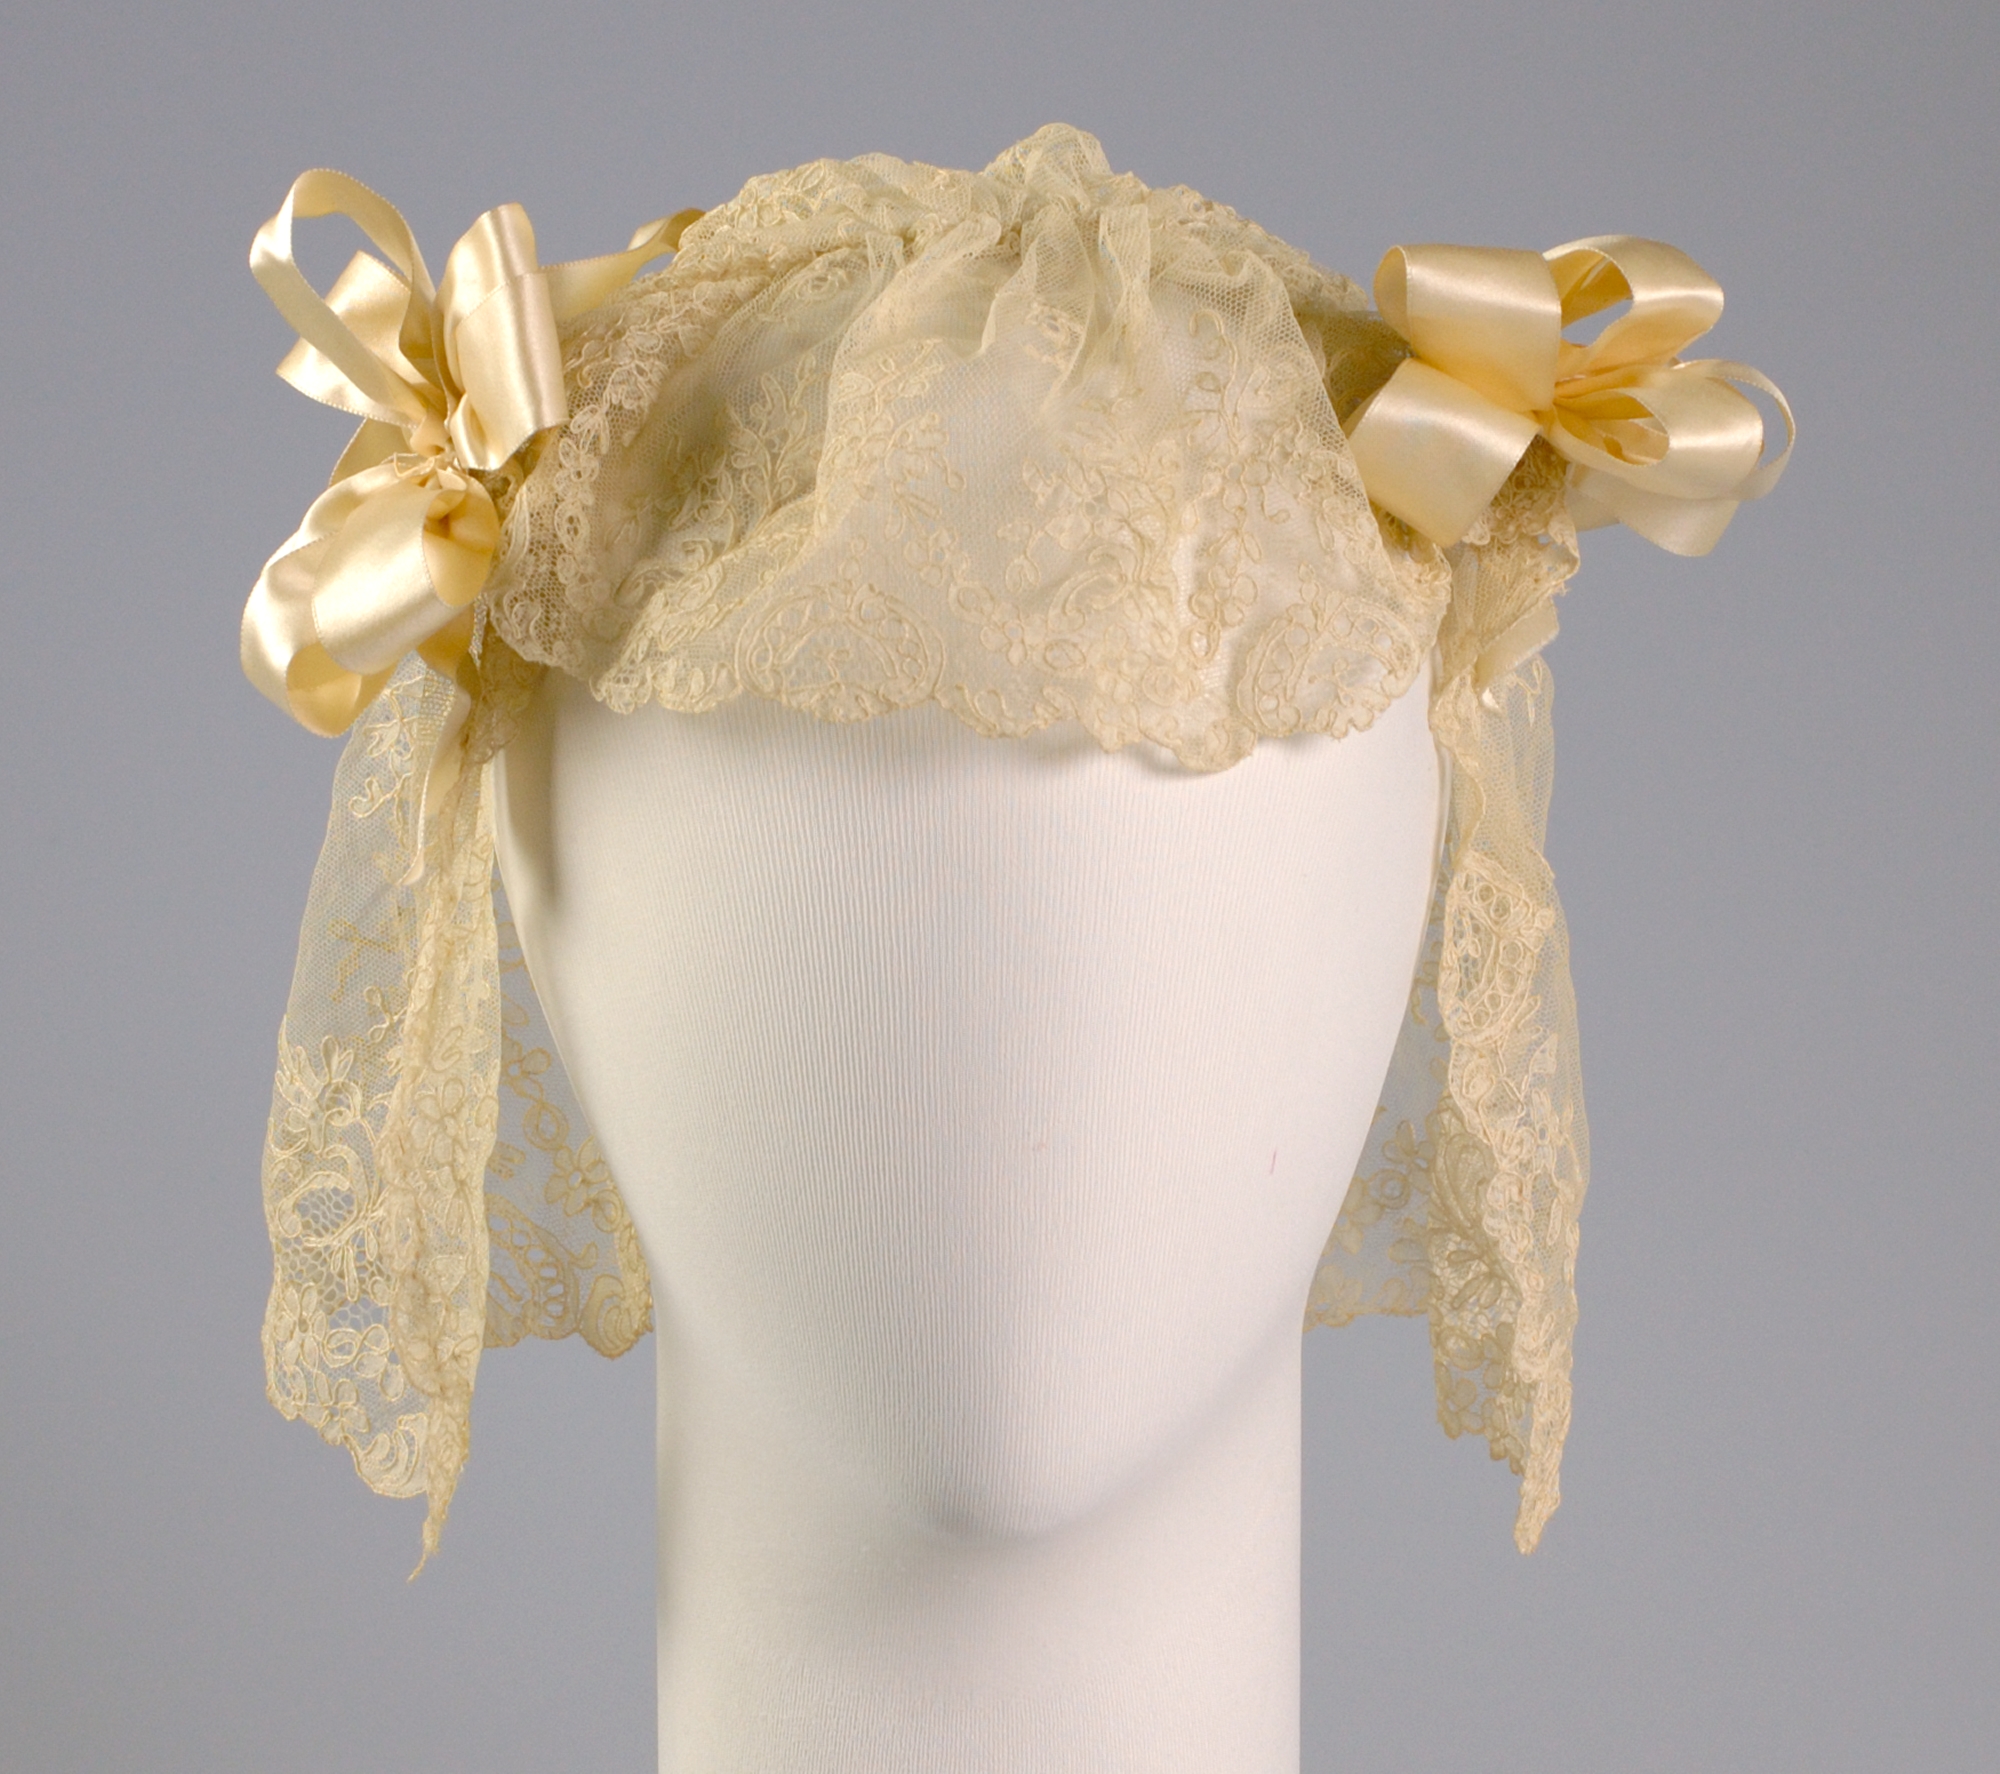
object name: evening cap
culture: american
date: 1885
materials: linen, silk